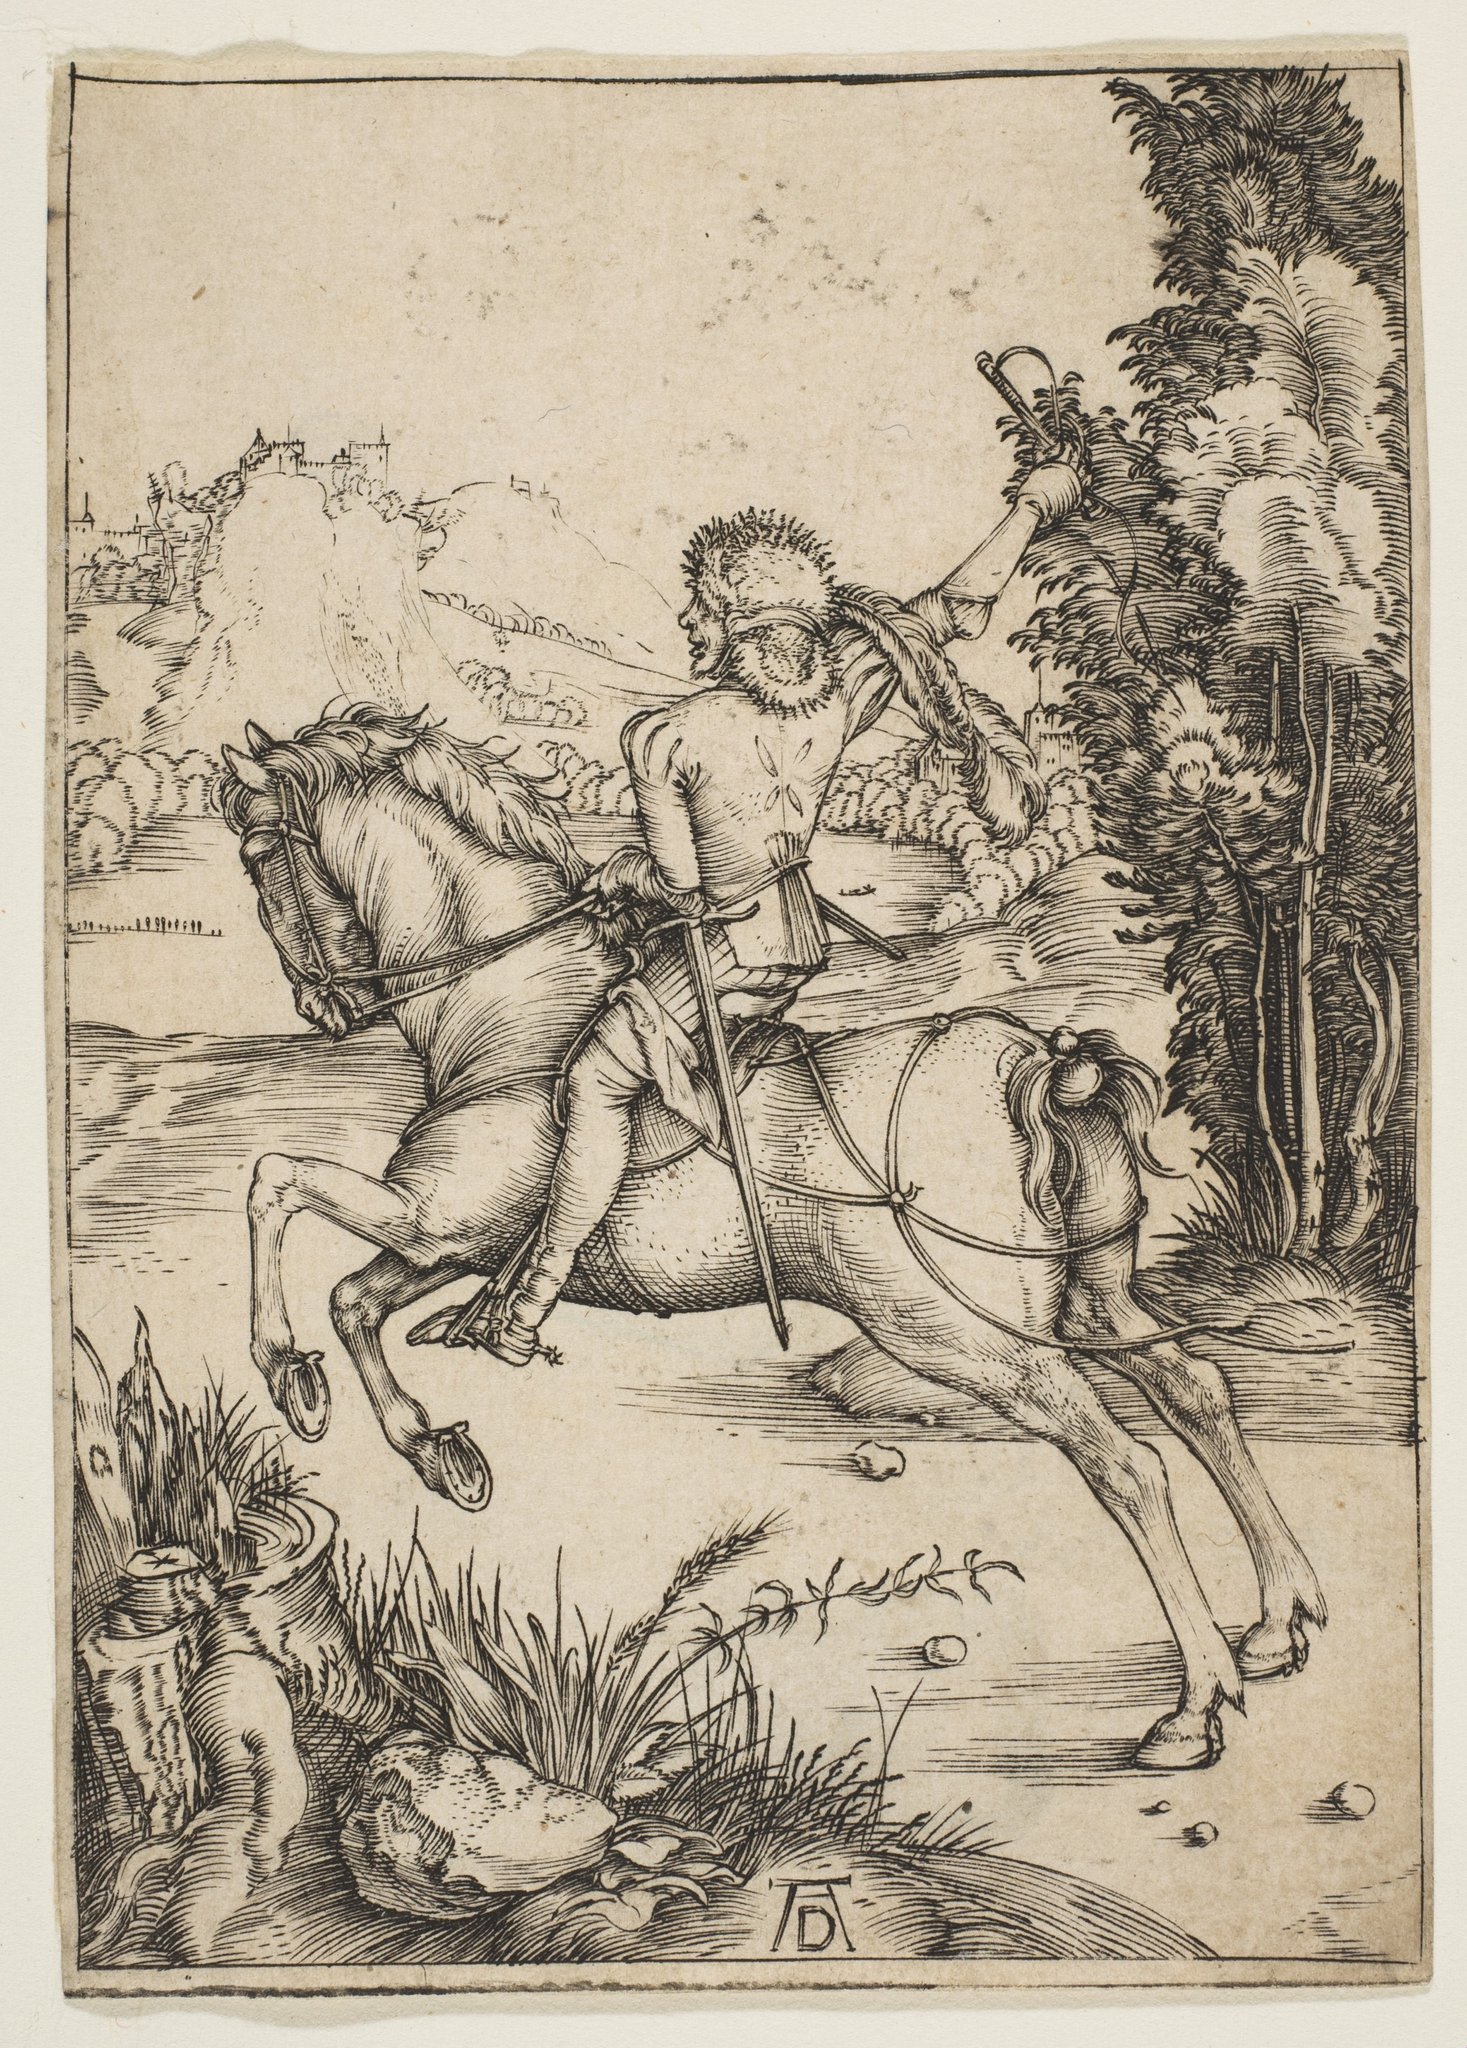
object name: print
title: The Little Courier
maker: albrecht dürer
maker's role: artist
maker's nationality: german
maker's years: 1471-1528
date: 1496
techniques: engraving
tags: men,horses,trees